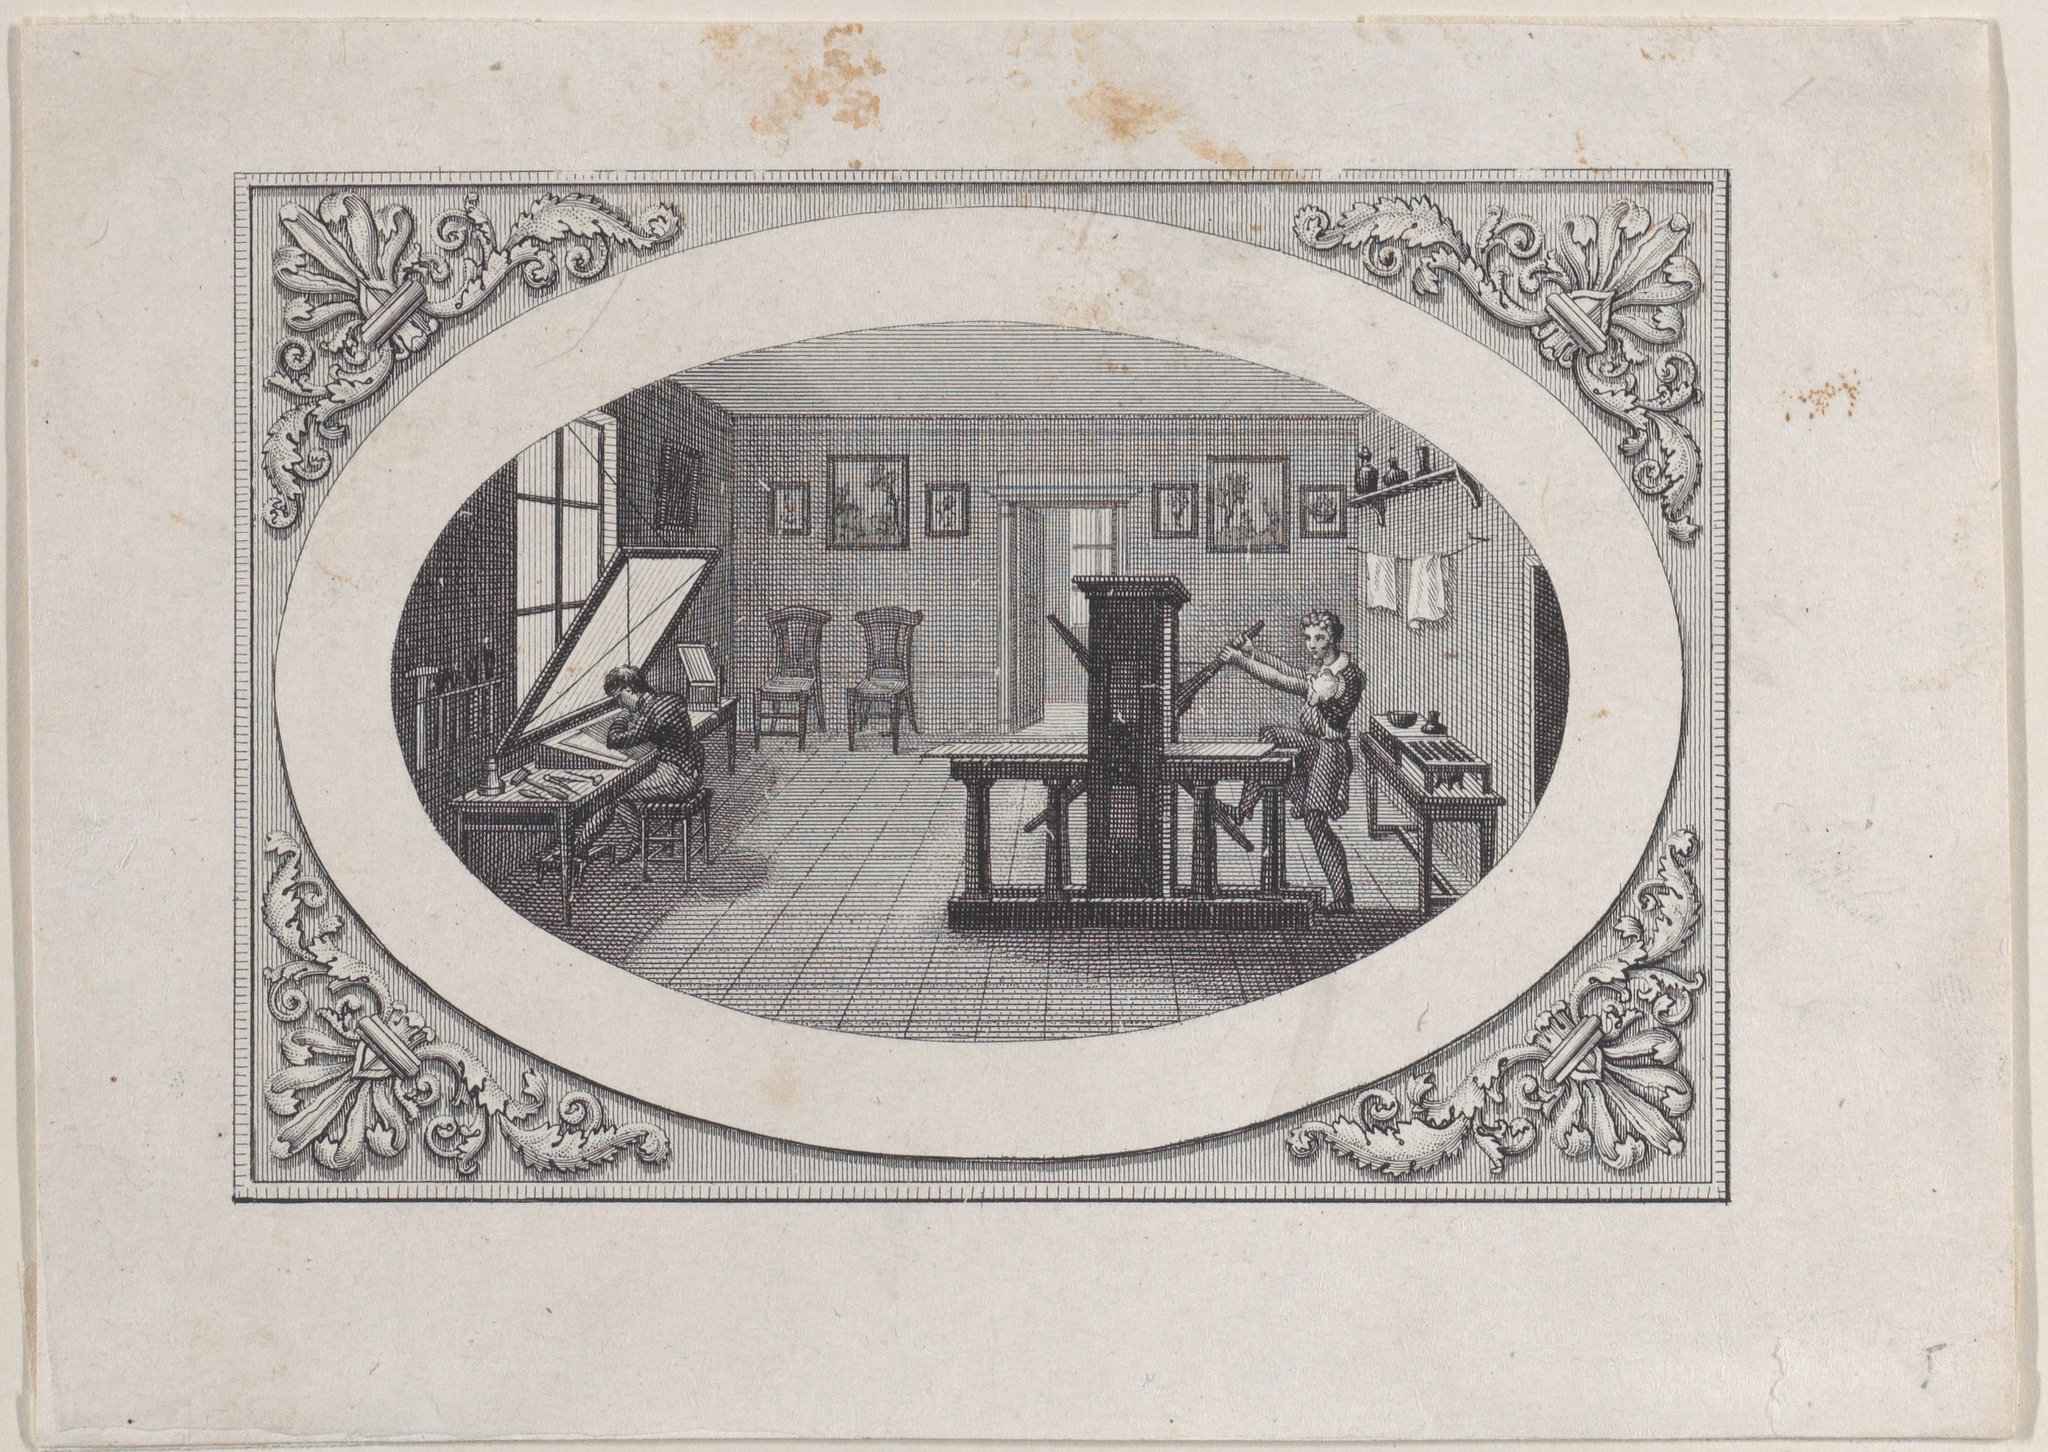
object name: print, trade card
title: Trade card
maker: anonymous, british, 19th century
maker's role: artist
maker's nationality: british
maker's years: 1800-1900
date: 1801-1900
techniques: engraving